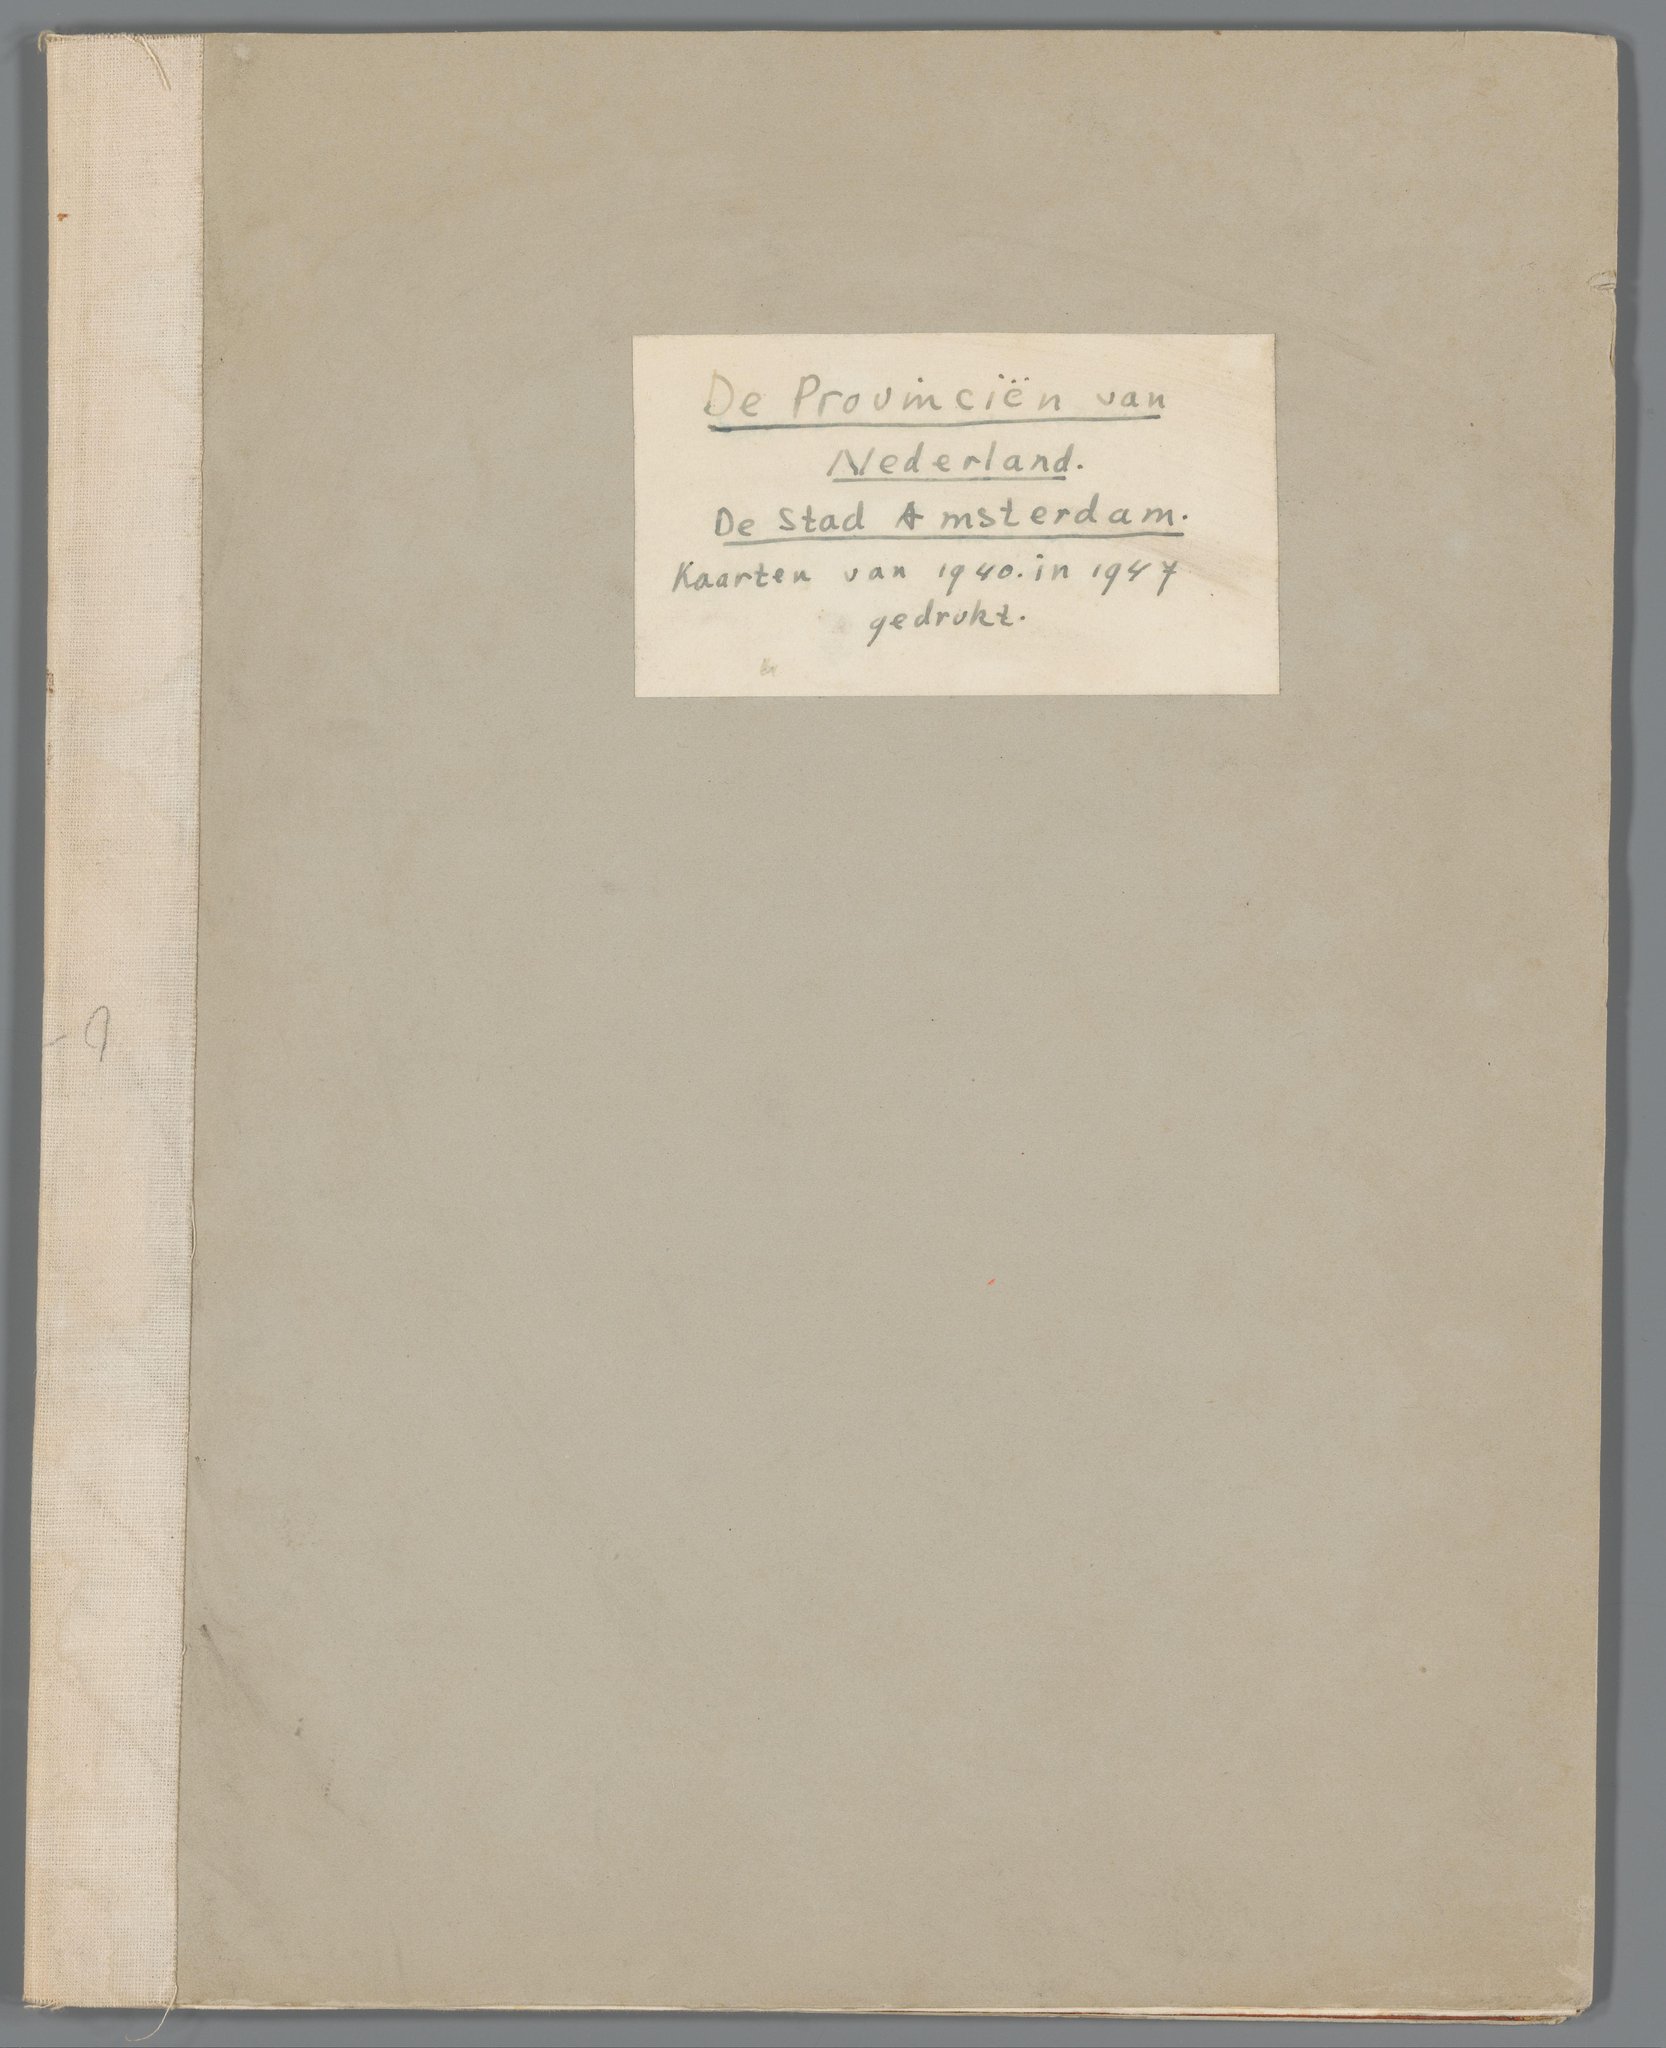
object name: book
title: De Provinciën van Nederland. De Stad Amsterdam. Kaarten van 1940, in 1947 gedrukt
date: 1947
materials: linen, paper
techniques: lithograph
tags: maps, atlases, netherlands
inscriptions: stamp: ‘J.G. Berkhout’, inscription: ‘De Provinciën van Nederland. De stad Amsterdam. Kaarten van 1940. in 1947 gedrukt.’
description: Omslag met twaalf kaarten van de Nederlandse provincies en de stad Amsterdam ingeplakt.